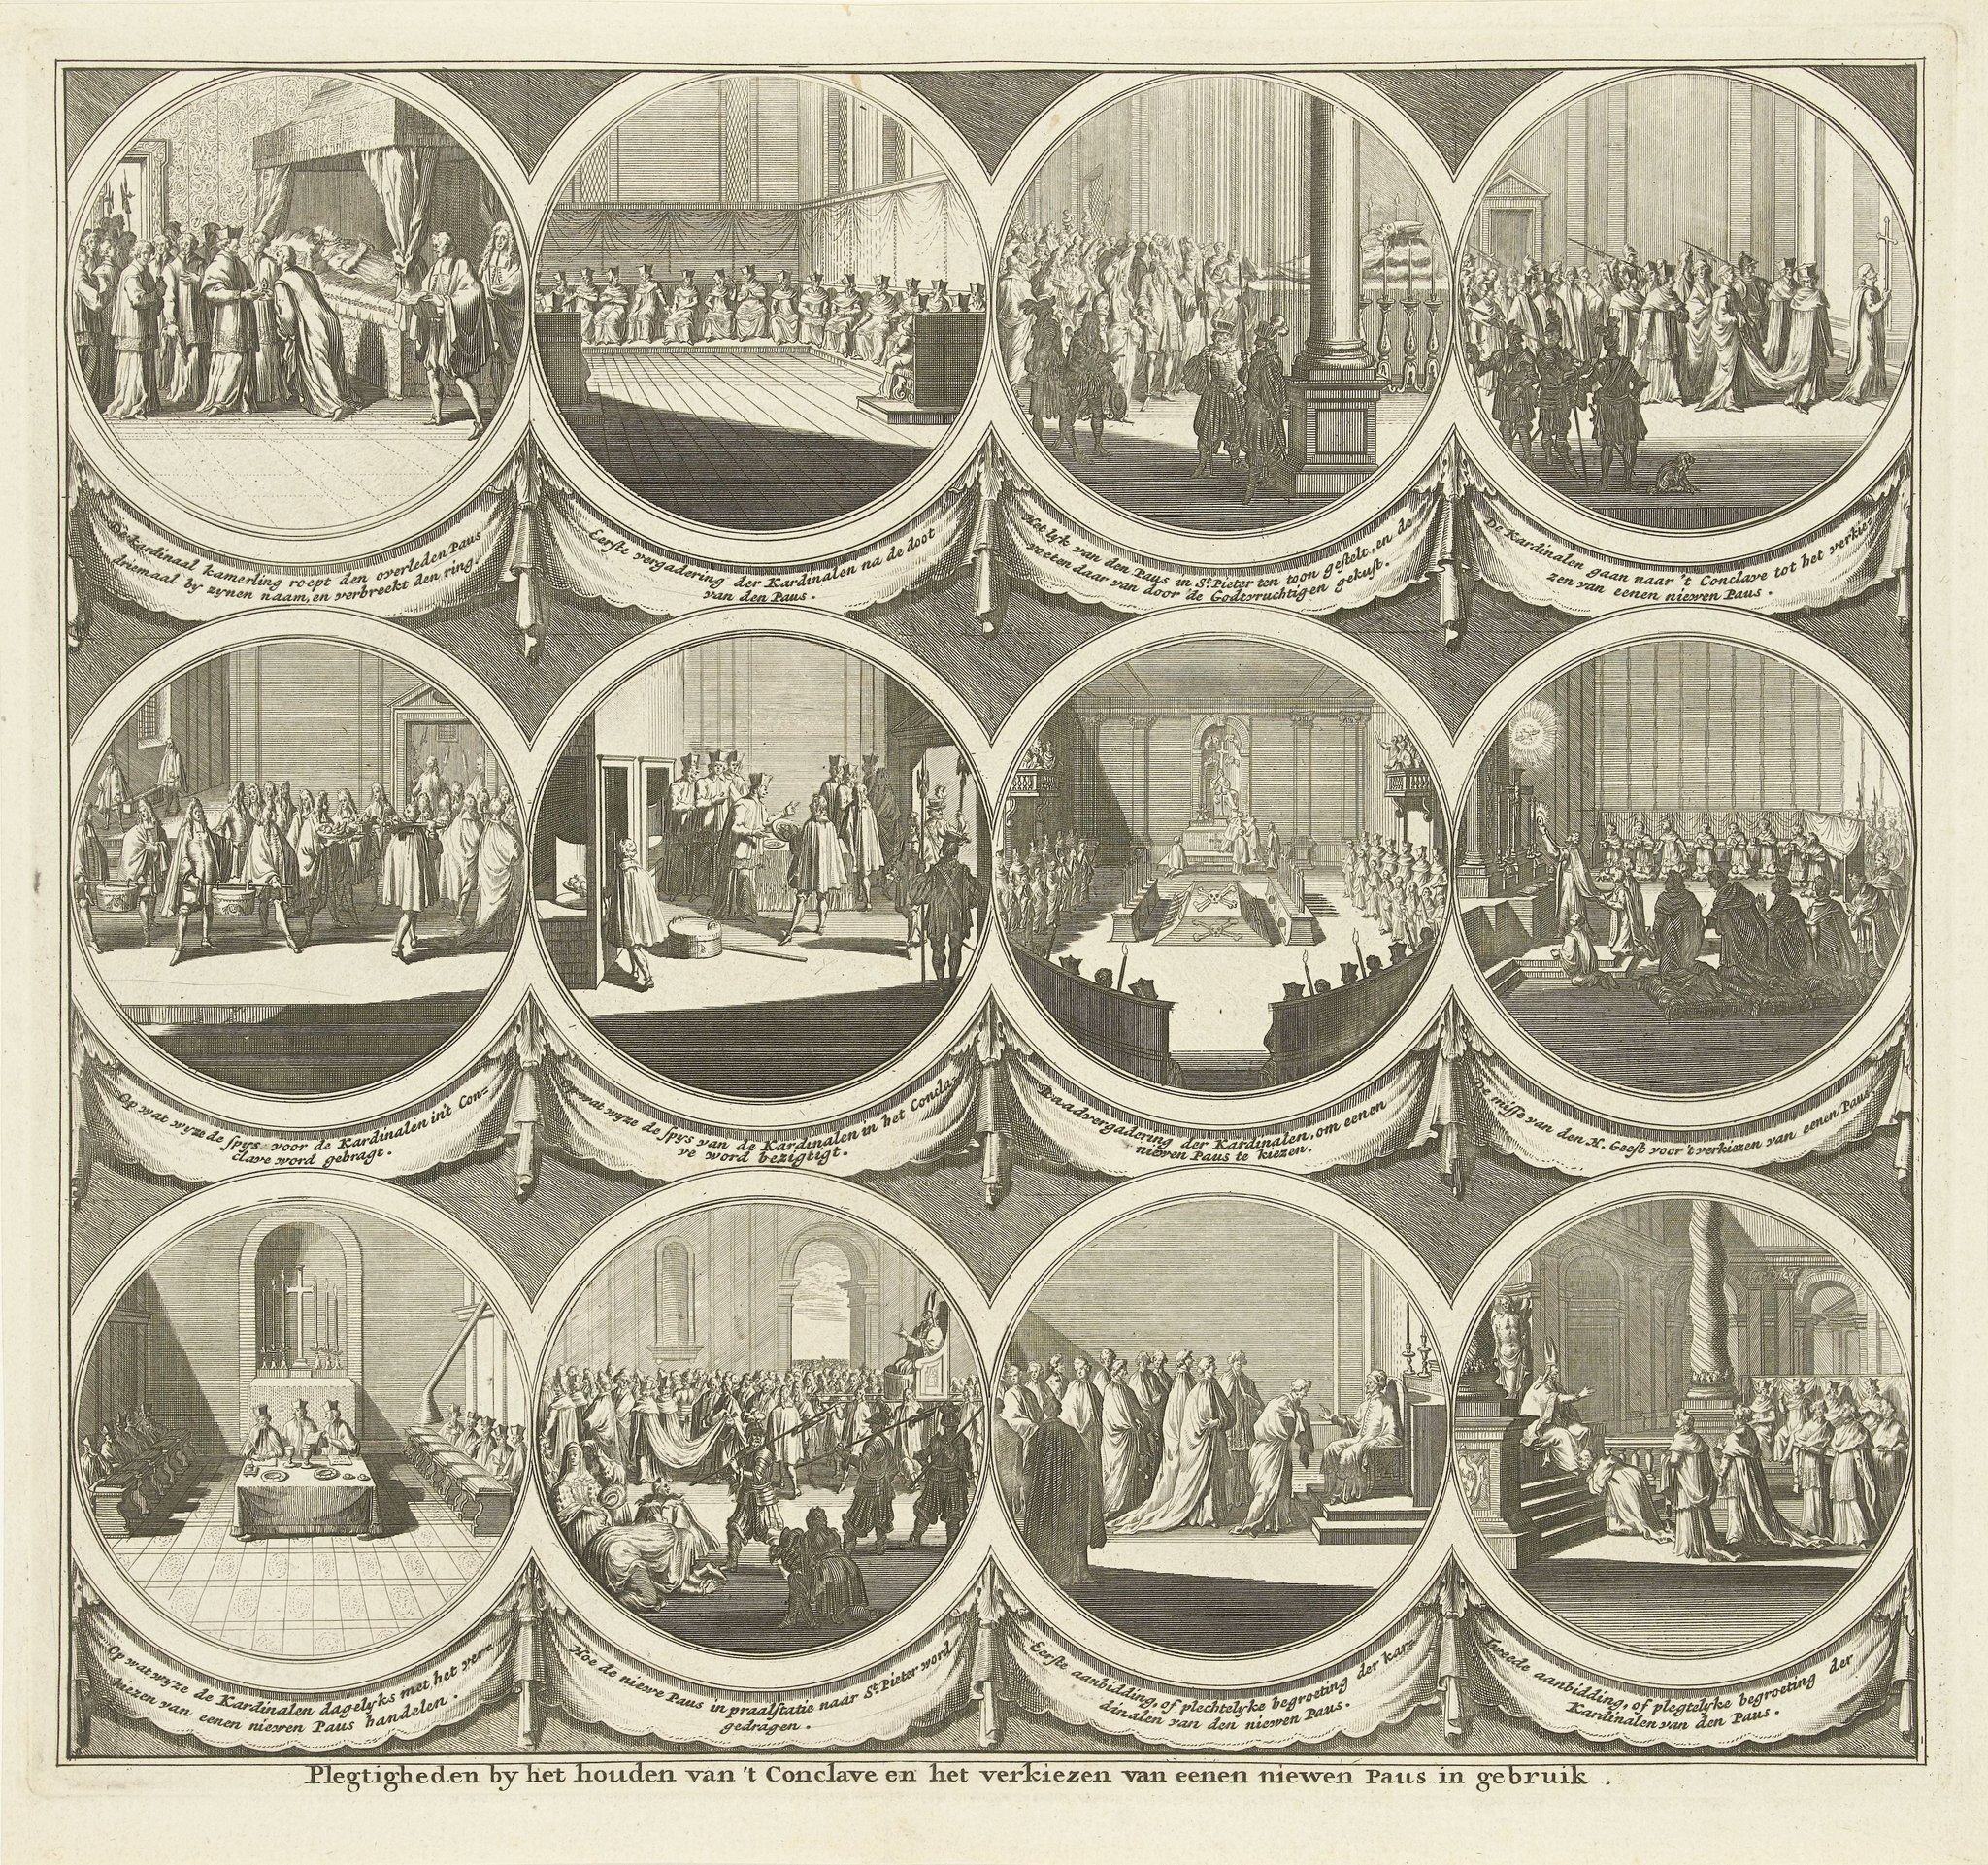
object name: print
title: Verkiezing van een nieuwe paus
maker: hendrik elandt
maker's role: print maker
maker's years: -1705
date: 1700-1705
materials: paper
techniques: etching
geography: amsterdam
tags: ceremonial celebrations ~ pope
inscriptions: collector's mark: Lugt 2228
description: Twaalf ronde cartouches tonen de verschillende plechtigheden vanaf het overlijden van een paus tot de benoeming van een nieuwe paus. Onder elk cartouche wordt de weergegeven plechtigheid kort in het Nederlands beschreven.